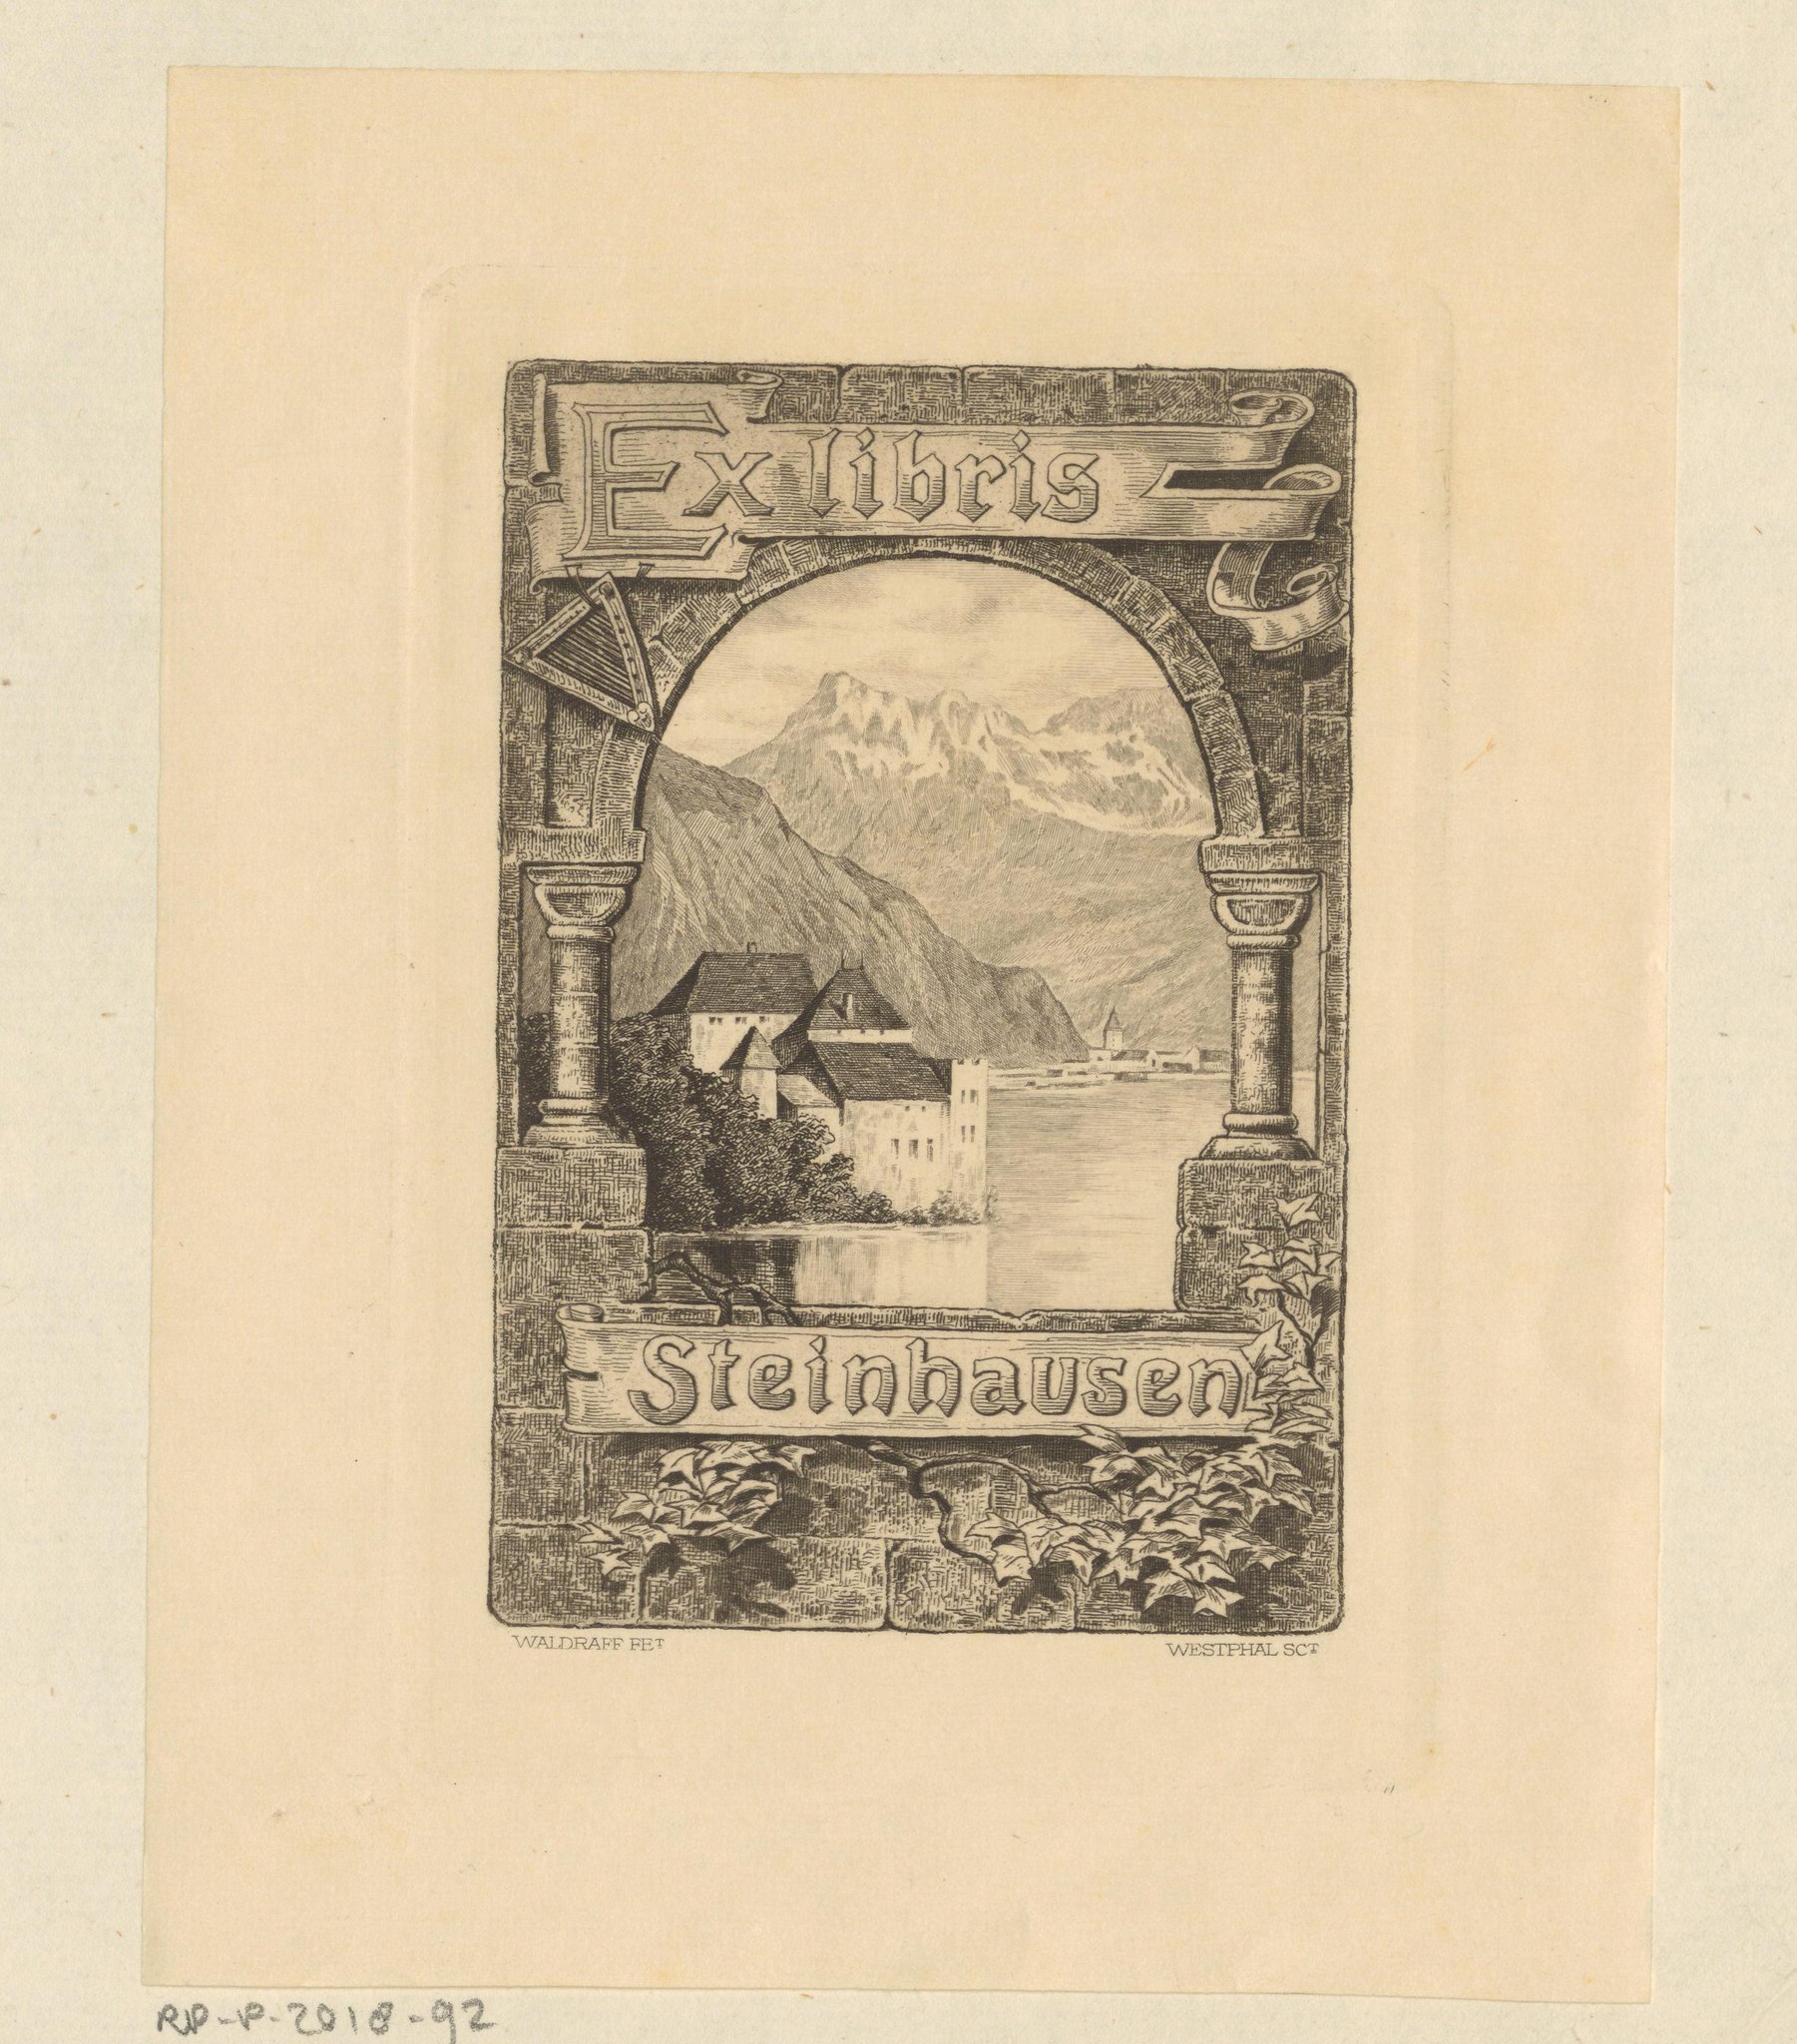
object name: bookplate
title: Ex libris van Steinhausen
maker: Anonymous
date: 1911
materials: paper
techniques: drypoint, etching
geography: germany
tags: column, pillar ~ architecture, castle, lake, mountains